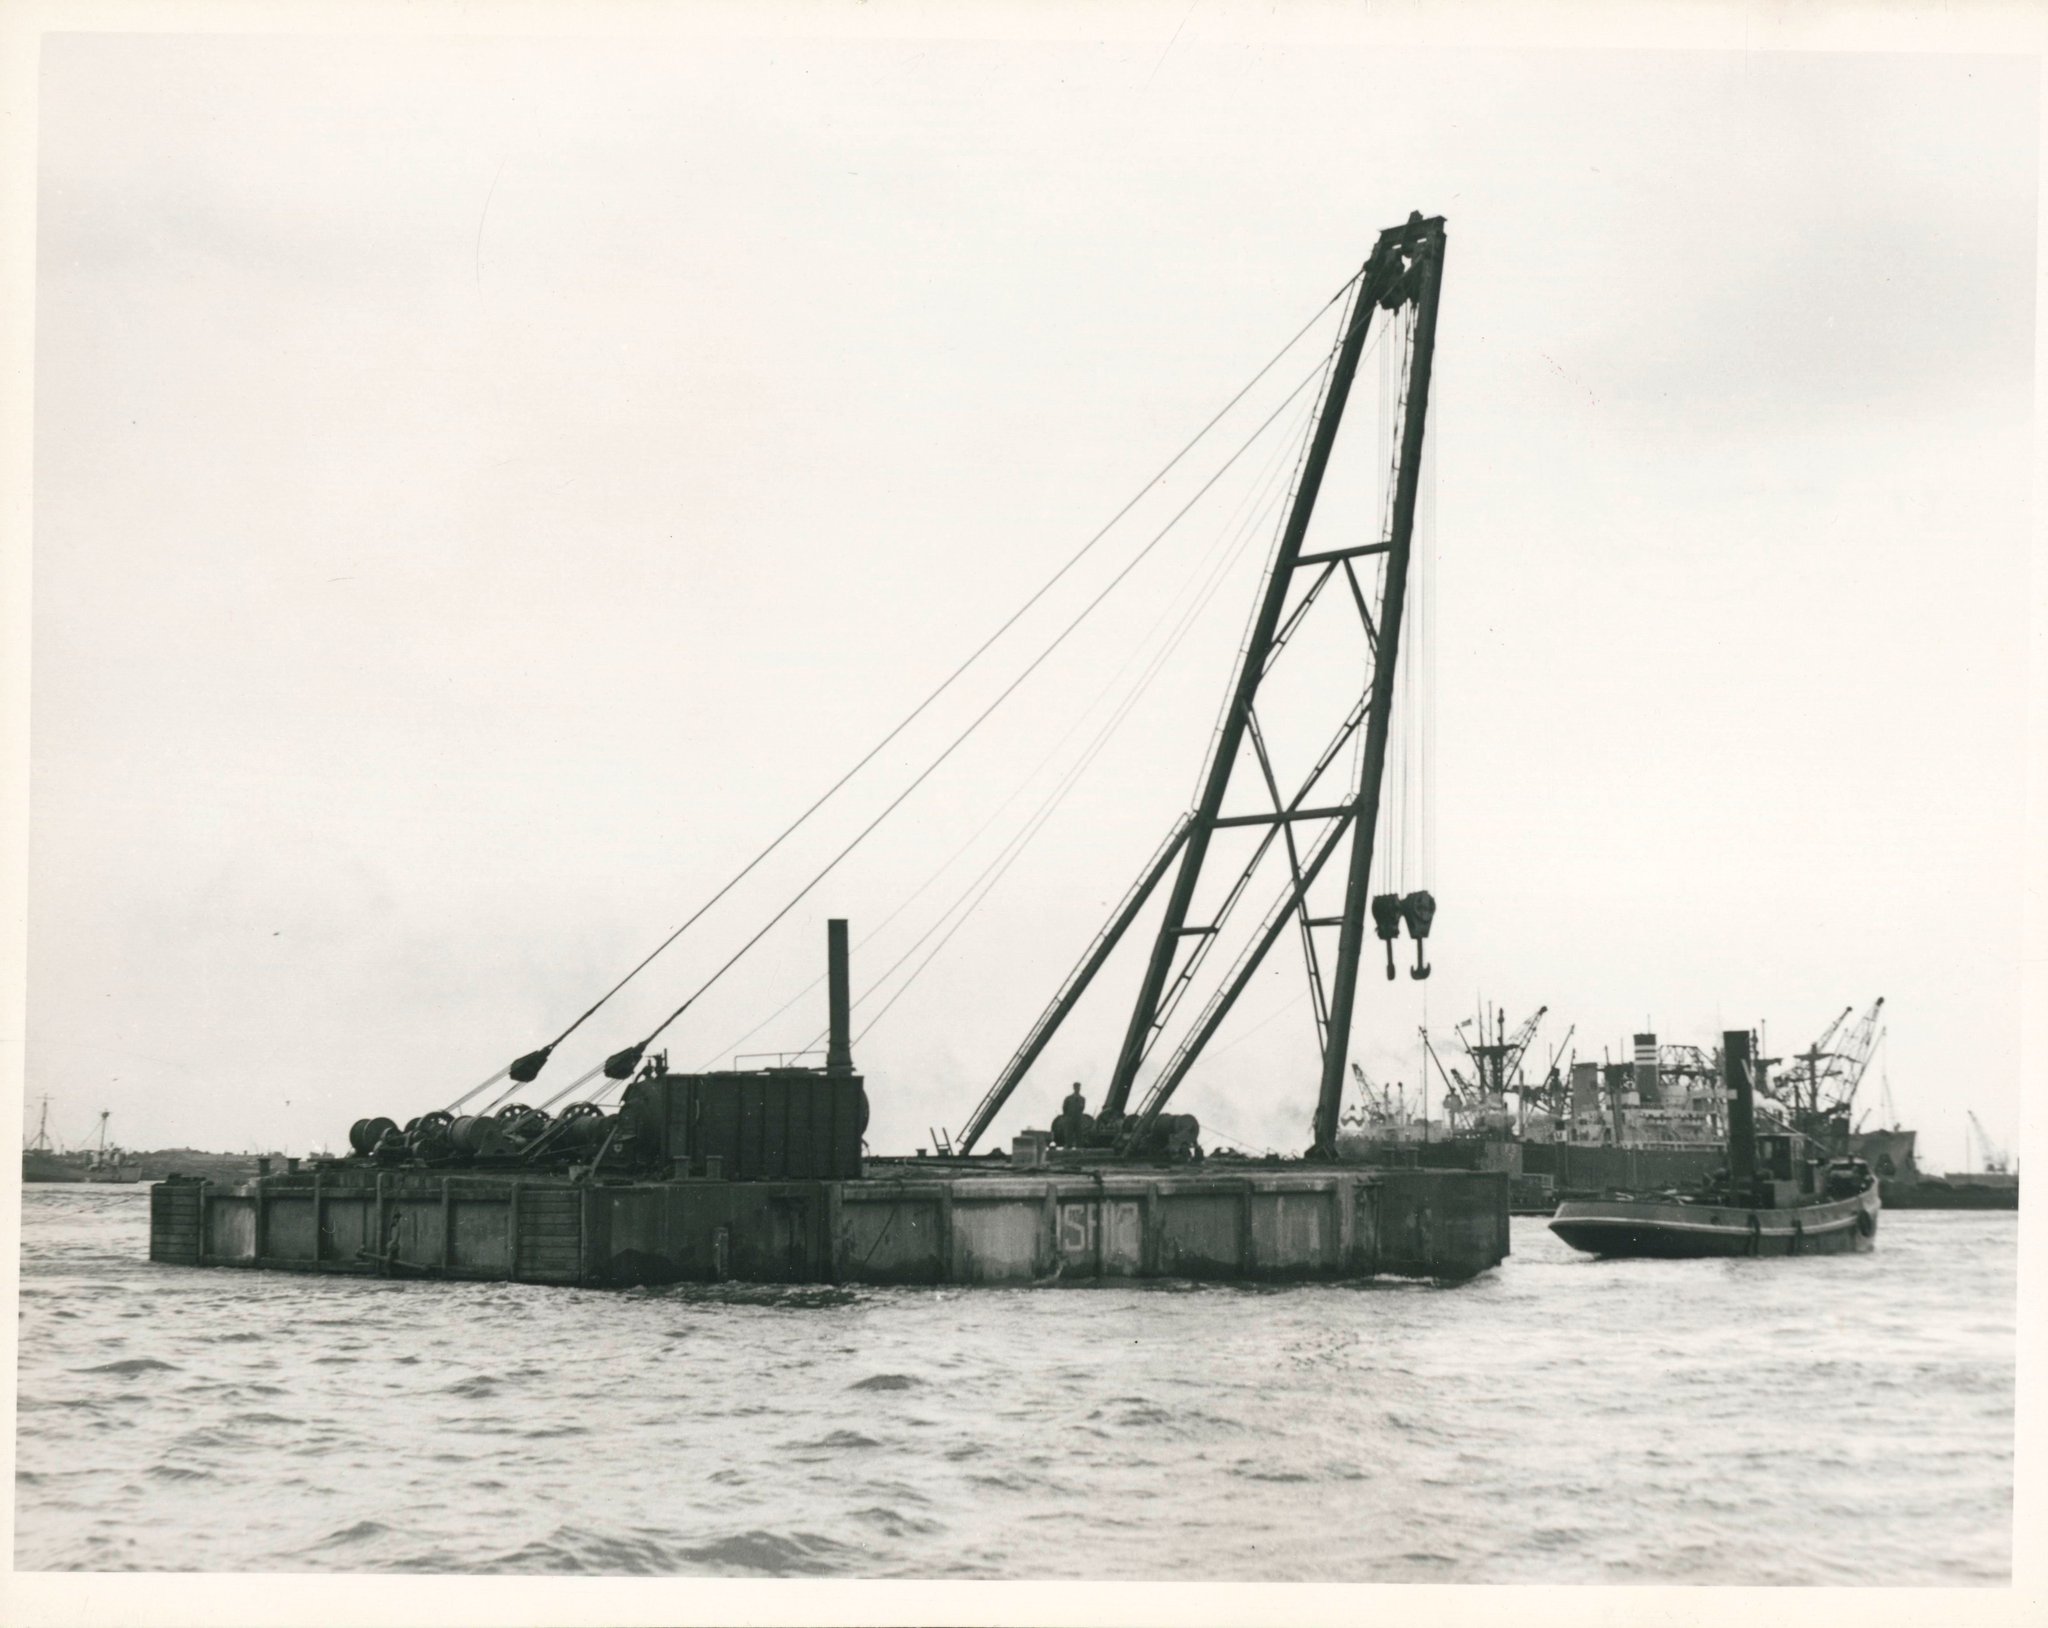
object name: documentary photograph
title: Herstel Rotterdamse haven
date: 1946-1947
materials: photographic support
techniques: photography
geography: rotterdam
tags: rotterdam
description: Met materiaal uit de USA wordt de Rotterdamse haven hersteld.